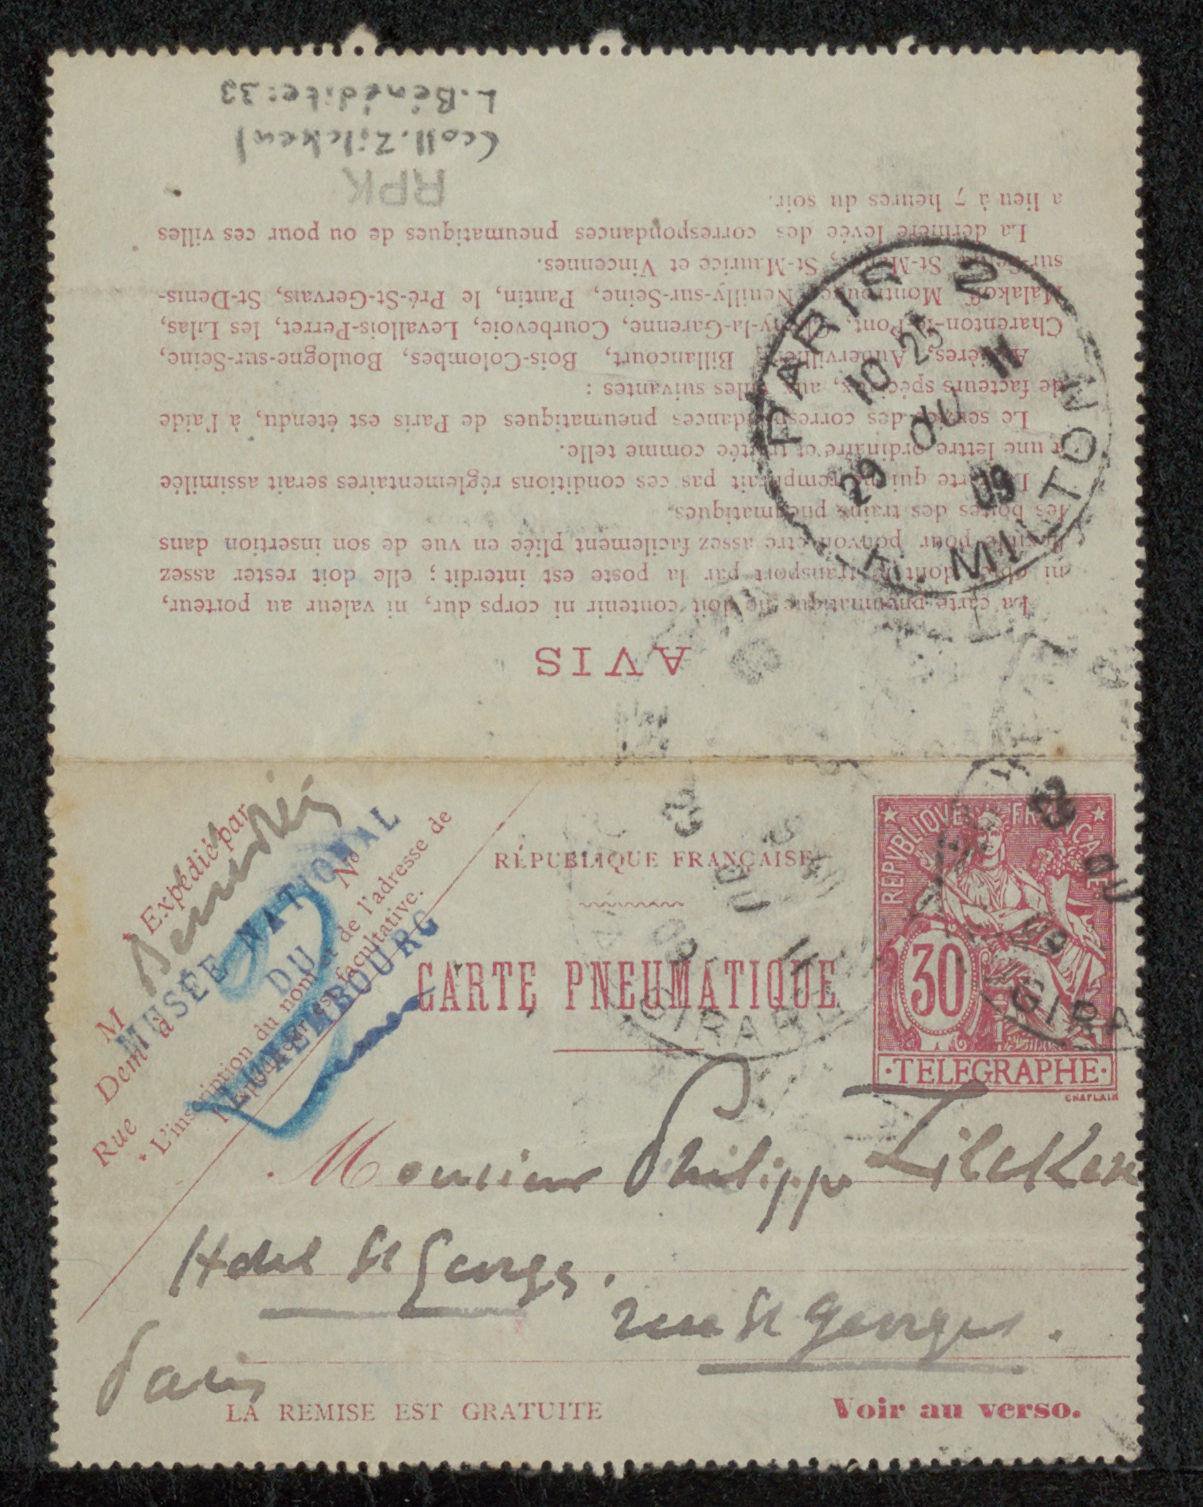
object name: postcard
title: Briefkaart aan Philip Zilcken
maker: léonce bénédite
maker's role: conservator, museumdirecteur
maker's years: 1856-1925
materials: ink, paper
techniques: pen, writing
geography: paris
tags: the hague, painter, draughtsman, philip zilcken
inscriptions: collector's mark: ‘RPK’